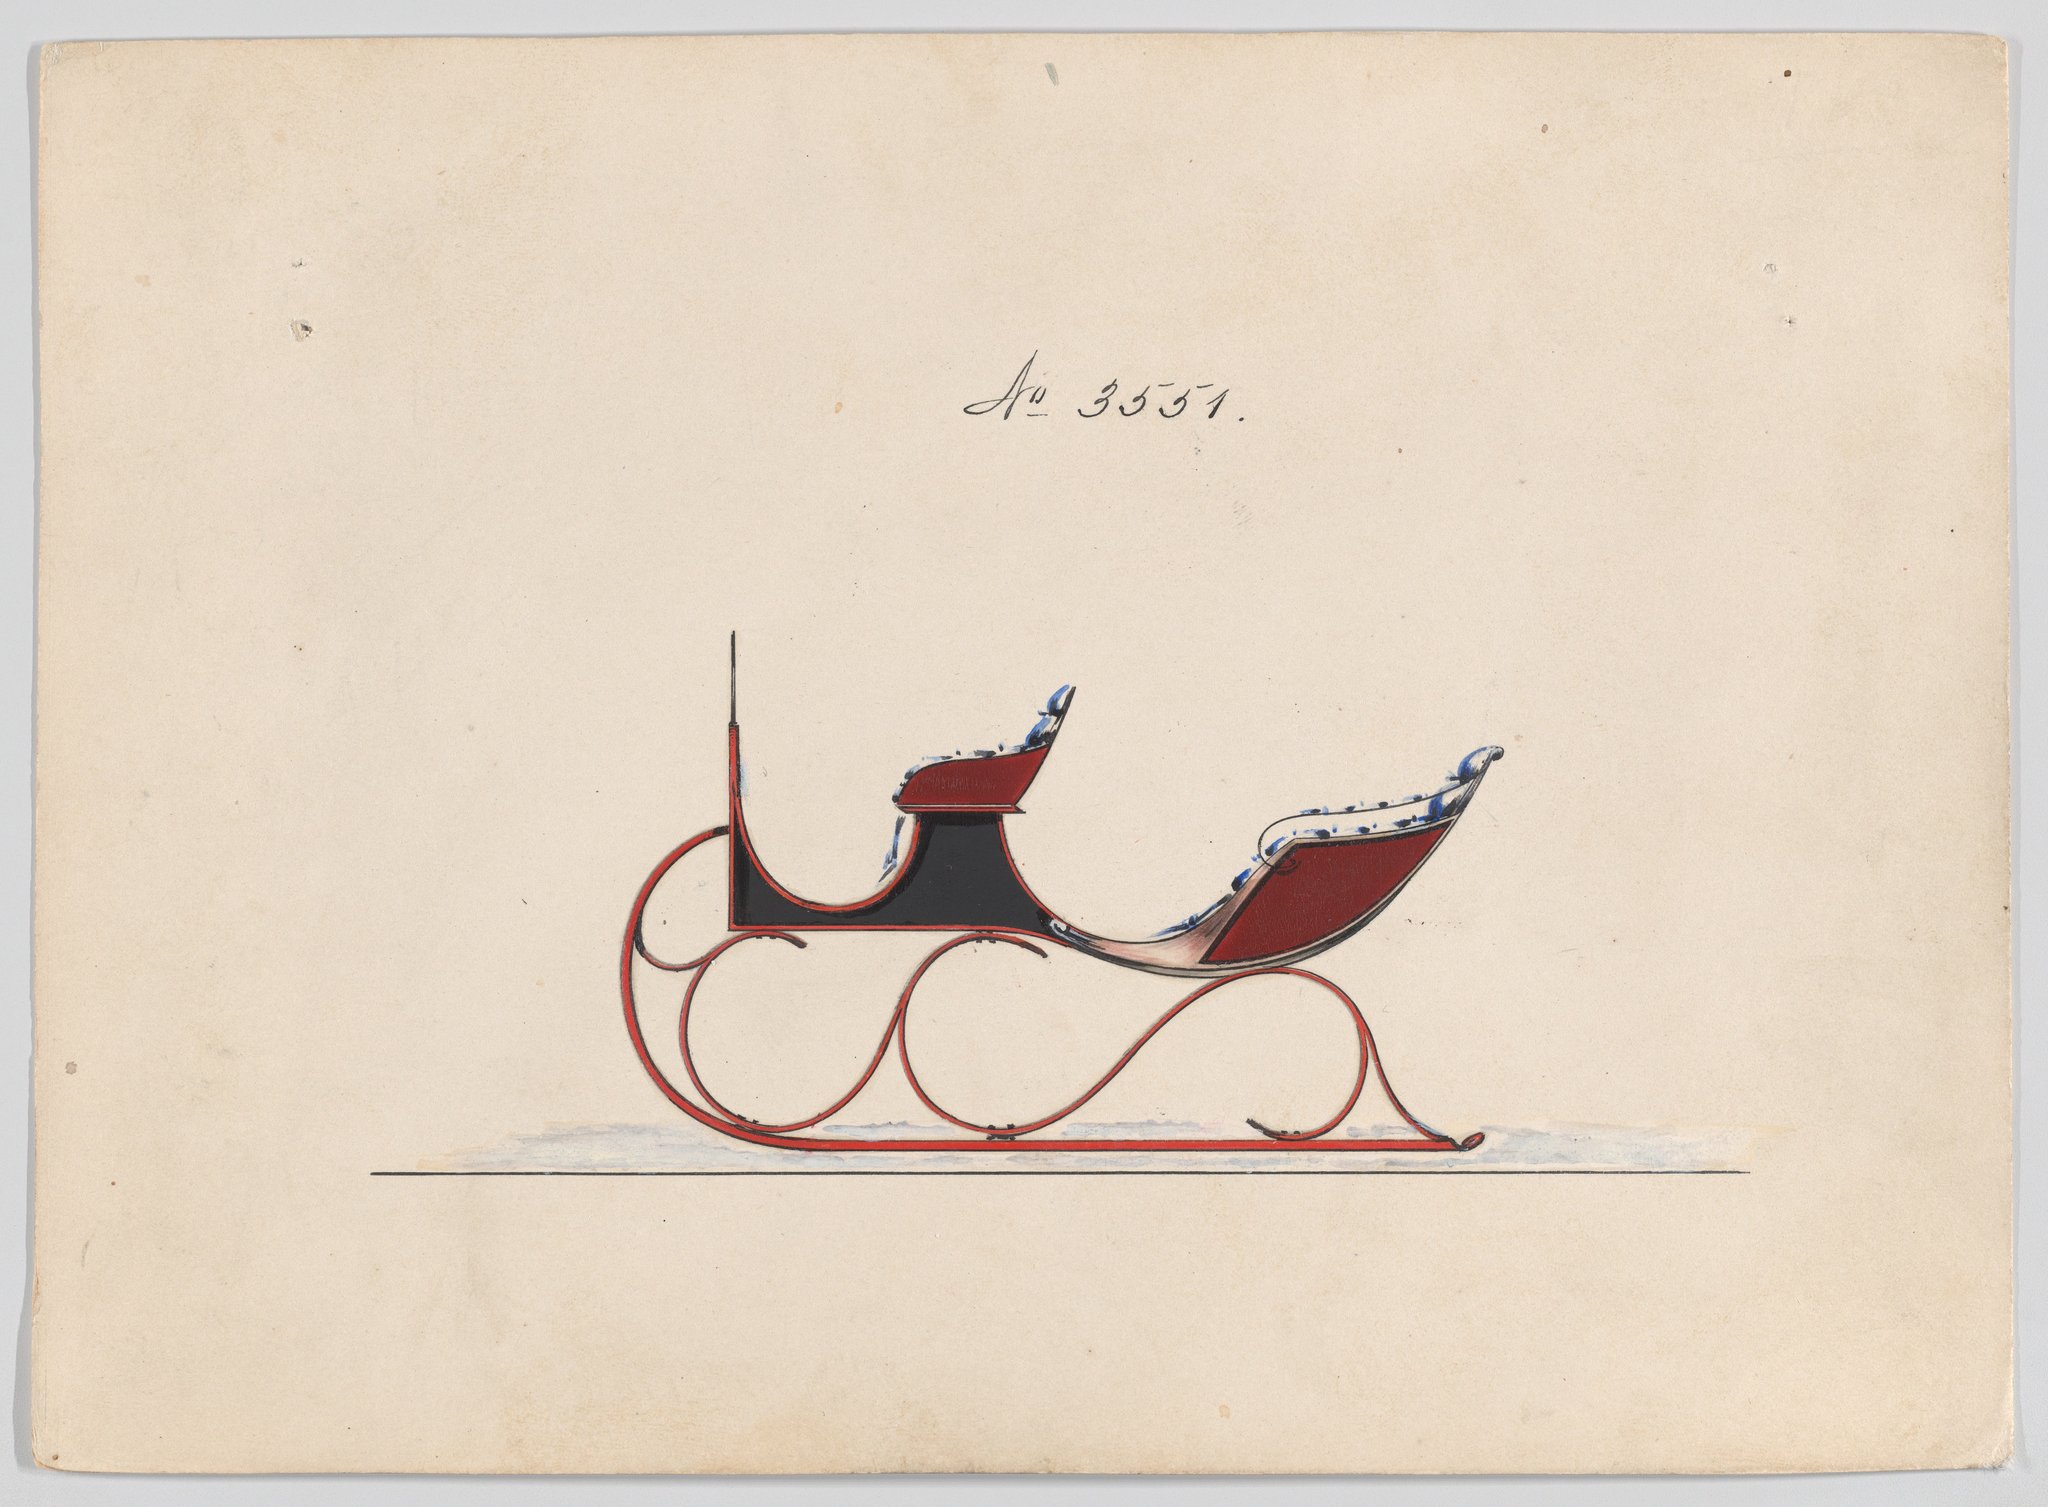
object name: drawing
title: Design for Victoria Sleigh, no. 3551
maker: brewster & co.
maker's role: manufacturer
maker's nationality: american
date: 1879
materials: gouache, gum arabic, ink, watercolor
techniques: pen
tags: sleighs